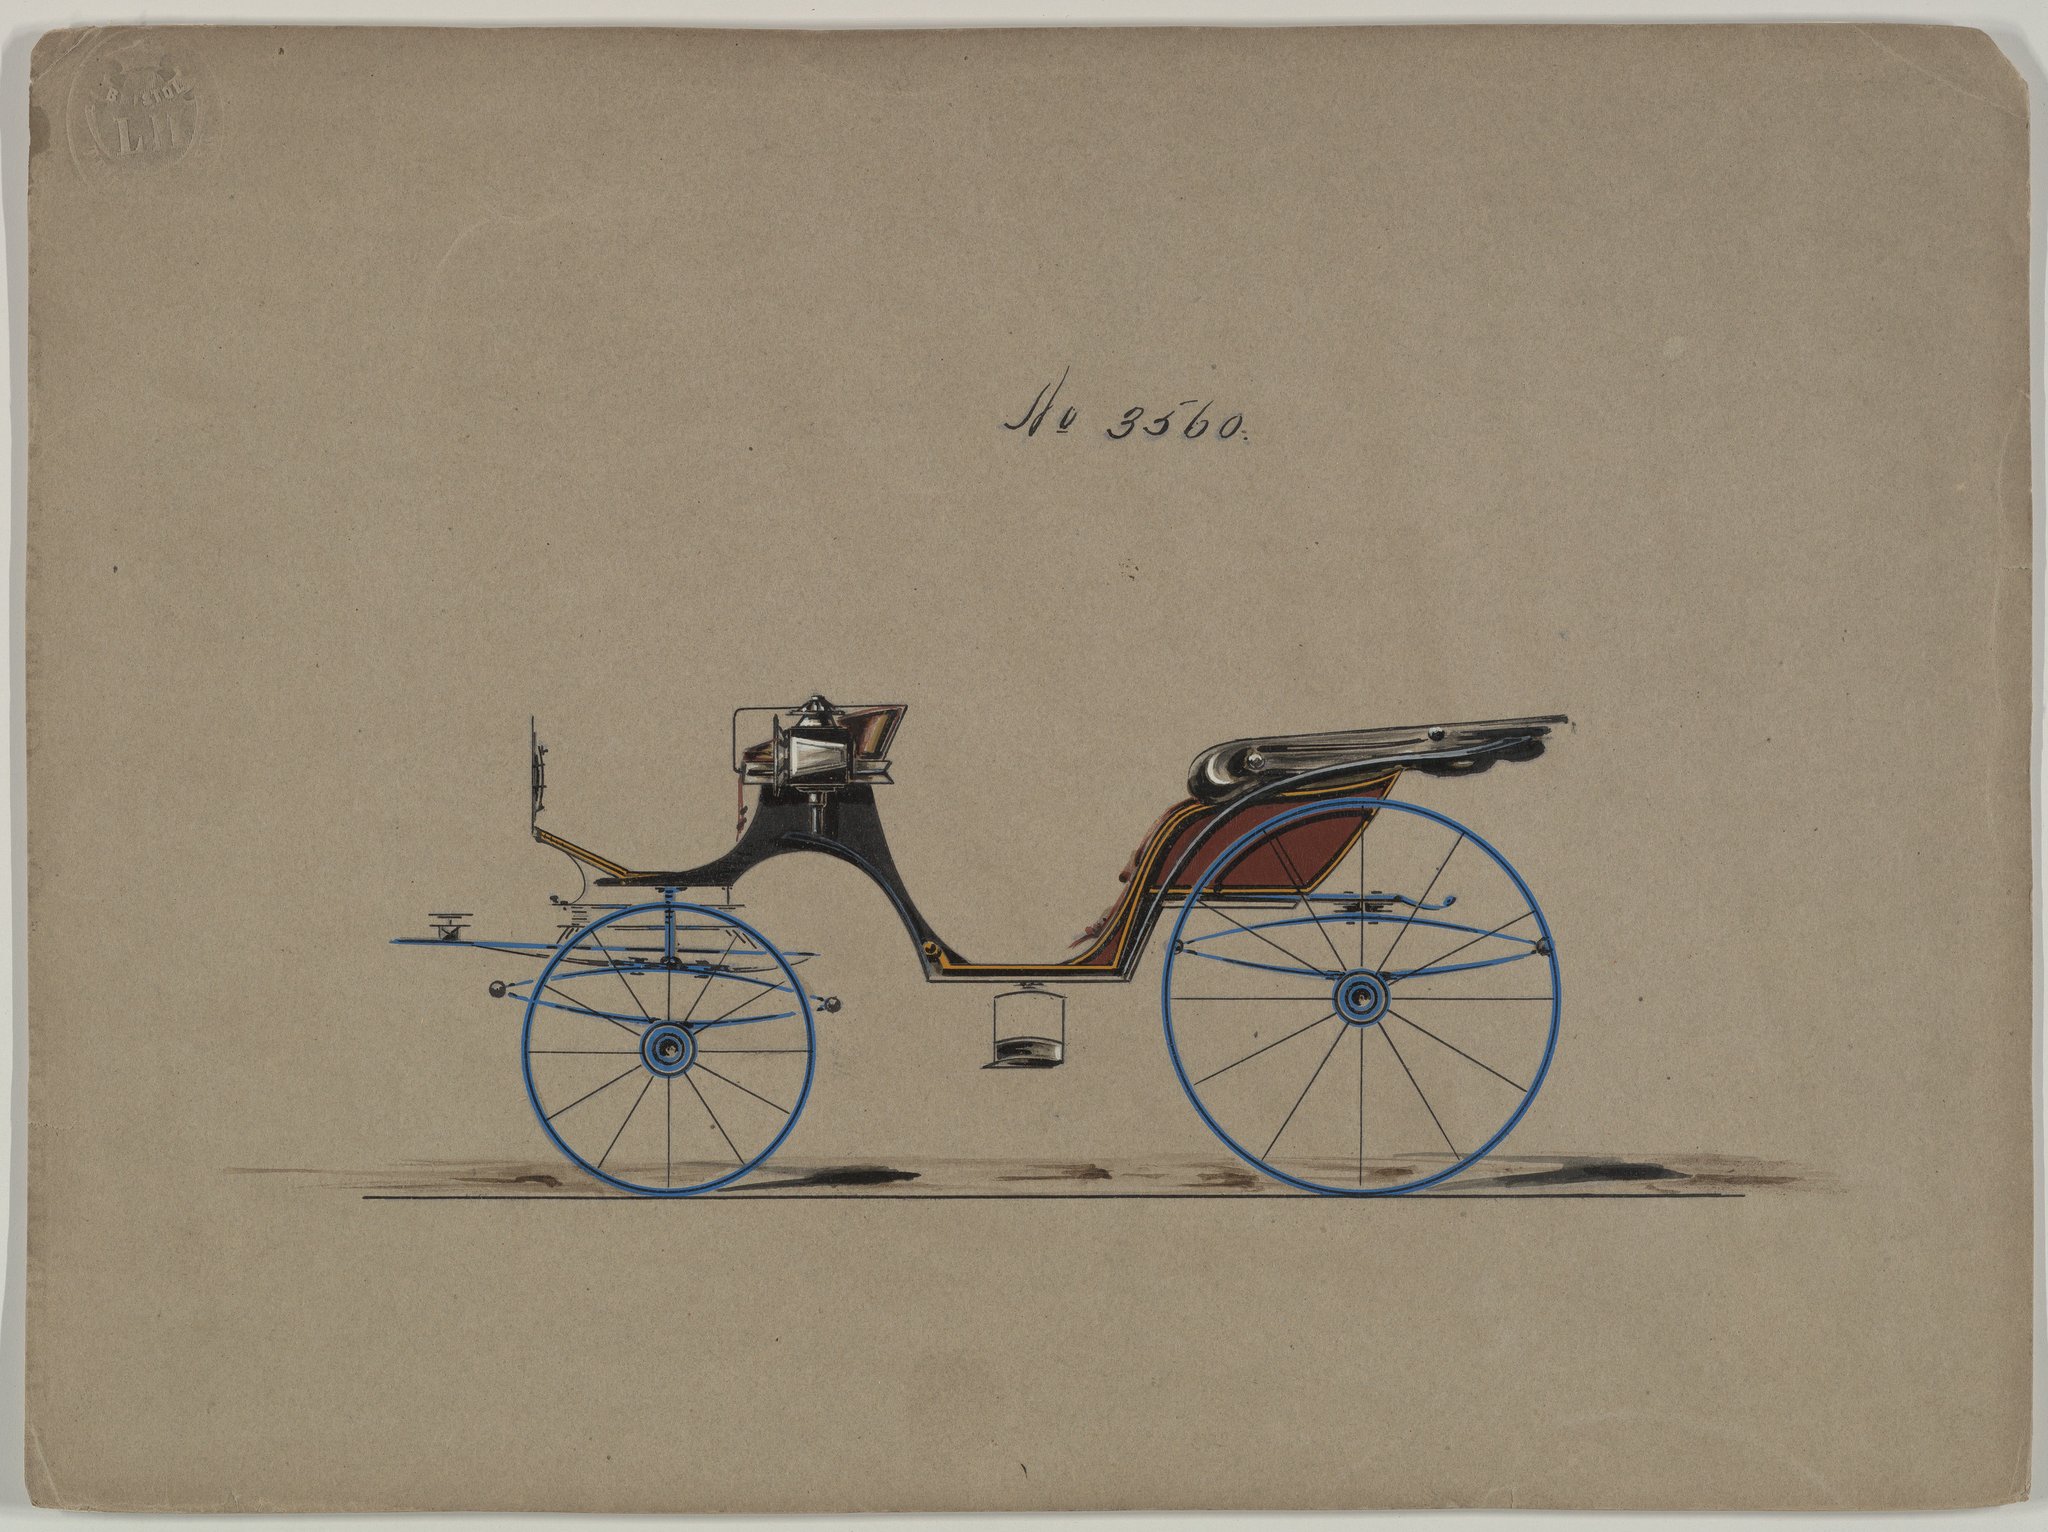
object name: drawing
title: Design for Cabriolet or Victoria, no. 3560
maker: brewster & co.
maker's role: manufacturer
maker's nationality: american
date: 1879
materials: gouache, ink, watercolor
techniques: pen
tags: carriages